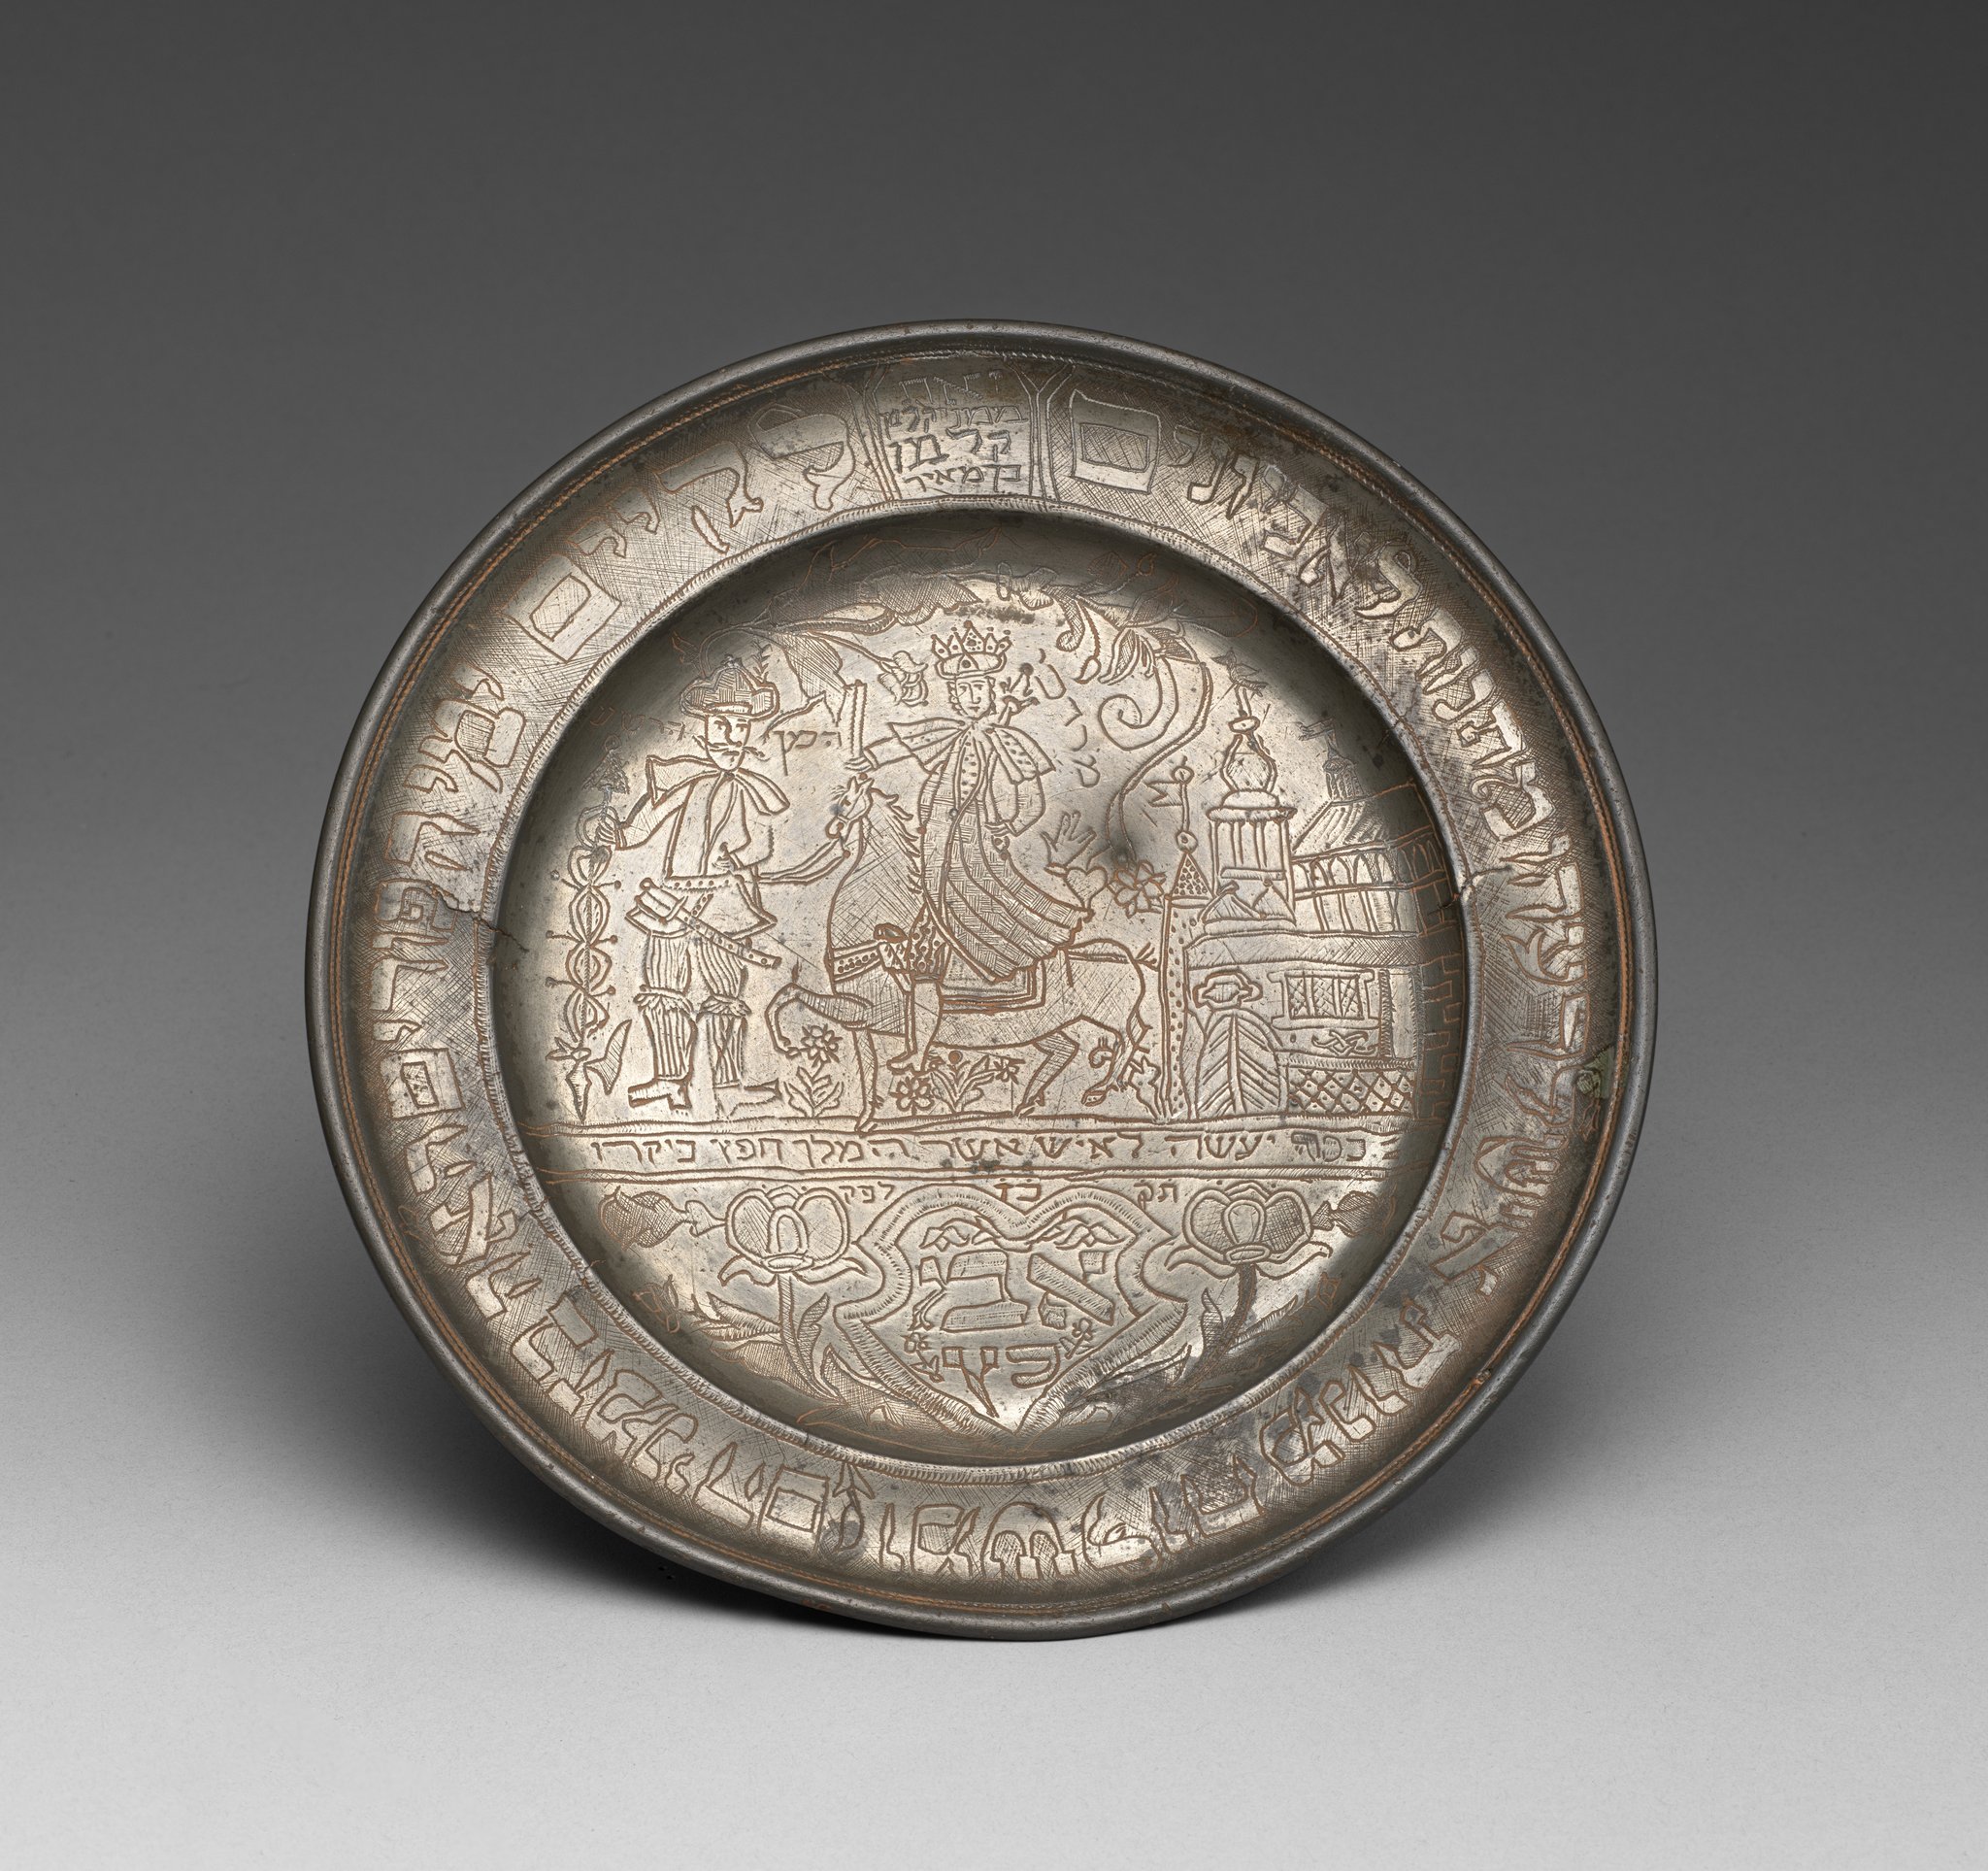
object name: plate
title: Purim plate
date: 1767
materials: pewter